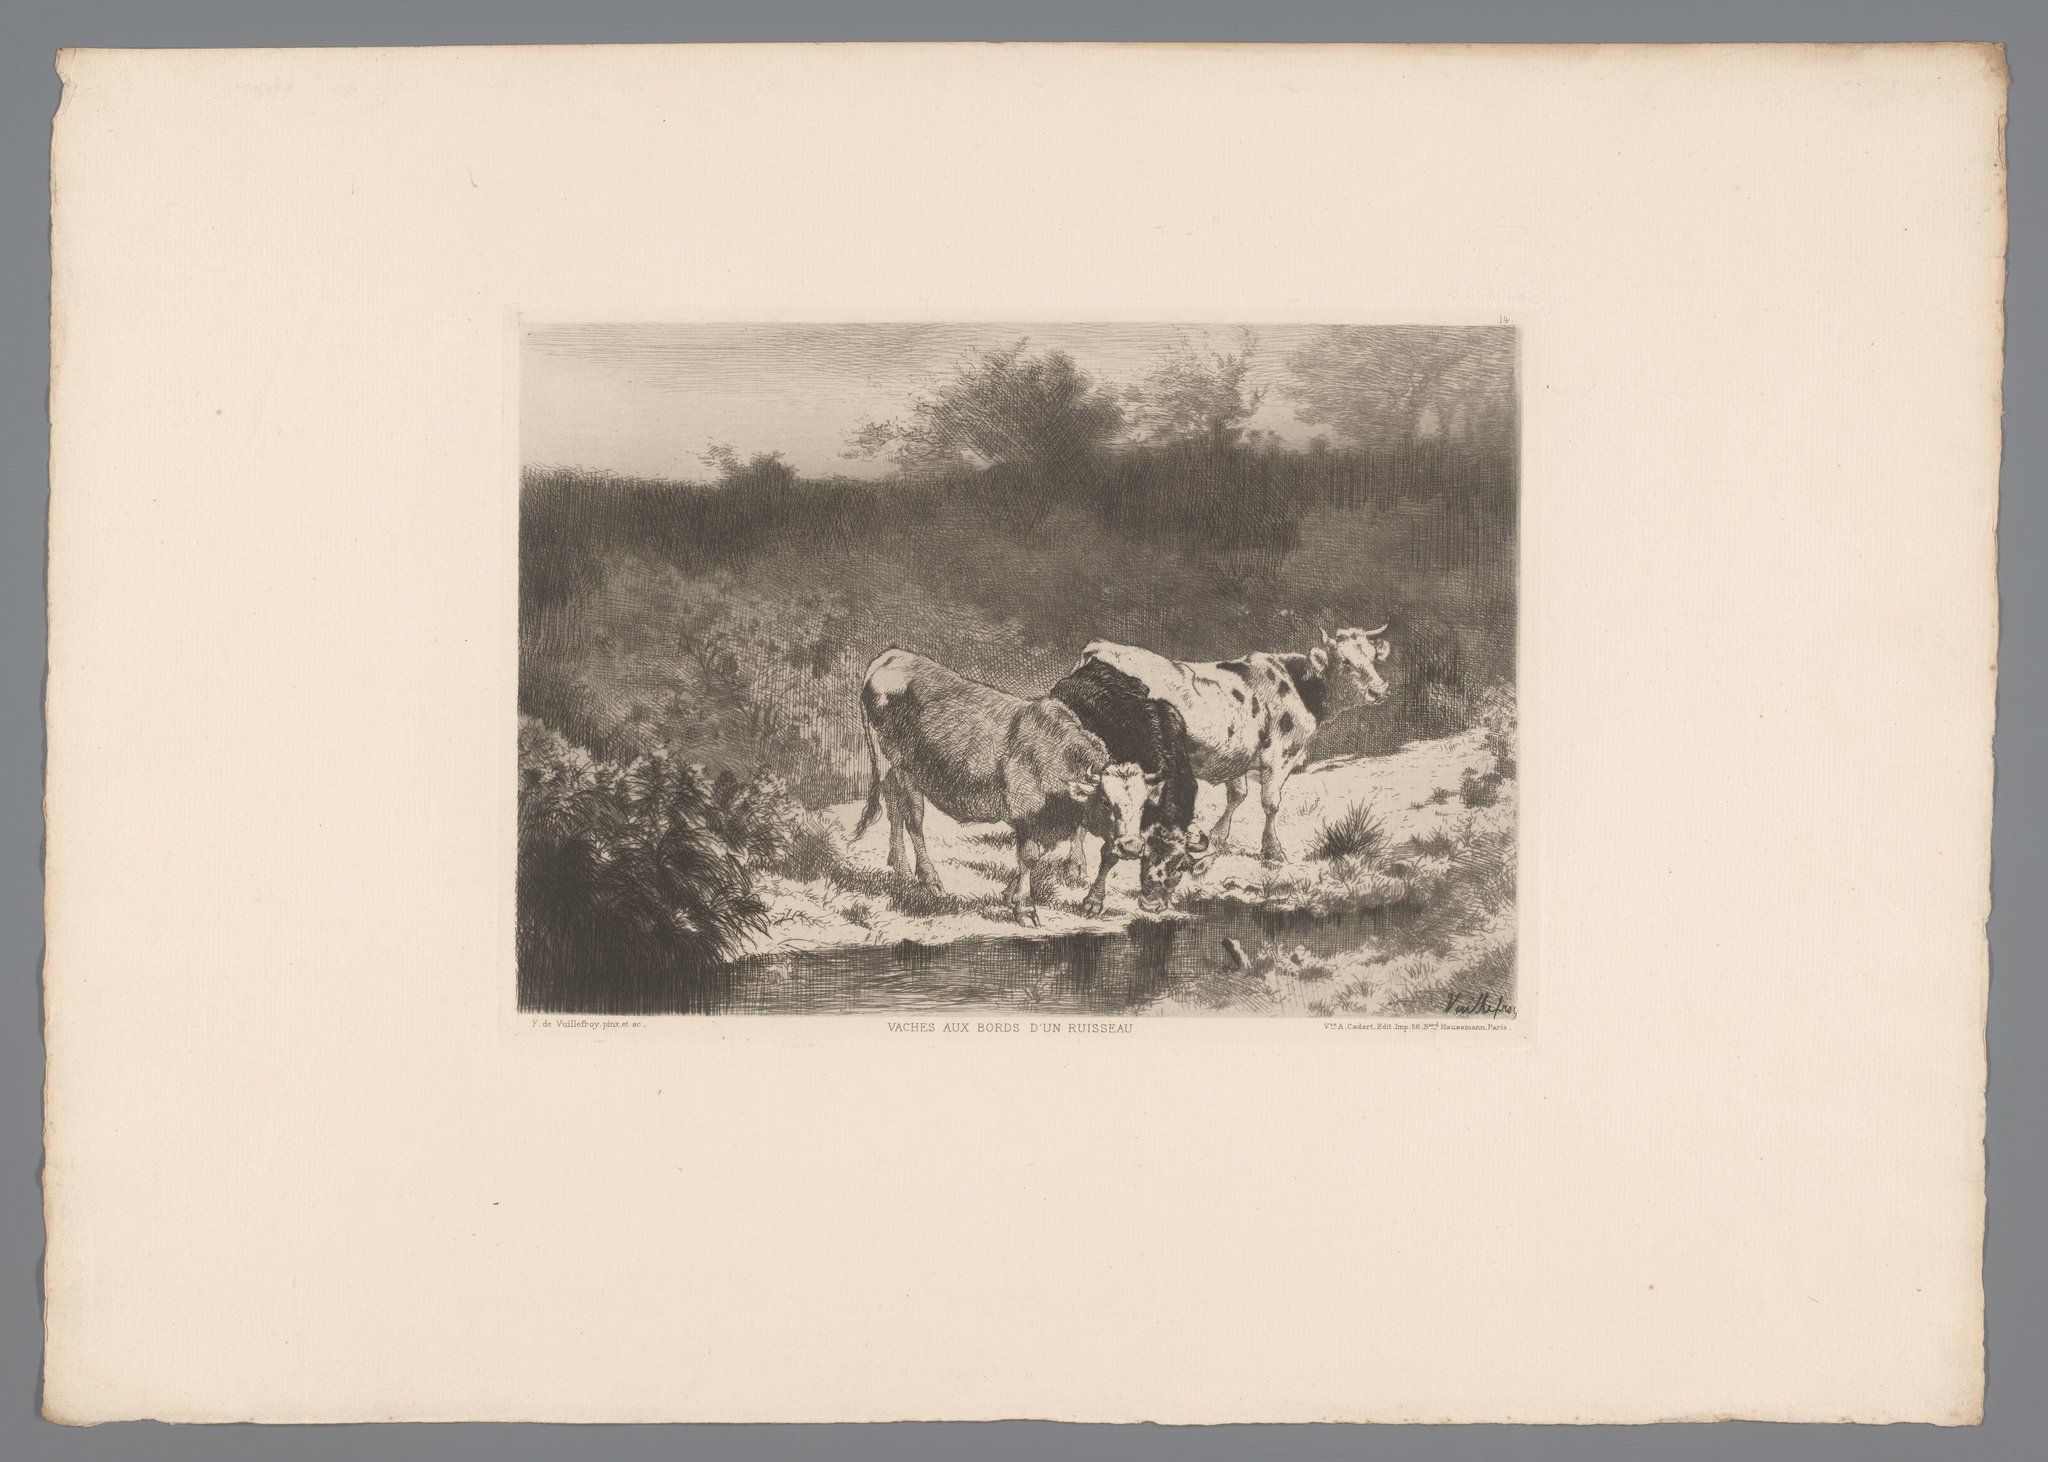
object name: print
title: L'eau-forte en 1880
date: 1880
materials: paper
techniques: drypoint, etching, intaglio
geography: paris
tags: cow, water course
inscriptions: collector's mark: ‘AFE v S’, collector's mark: Lugt 2228, watermark, collector's mark: Lugt 2760